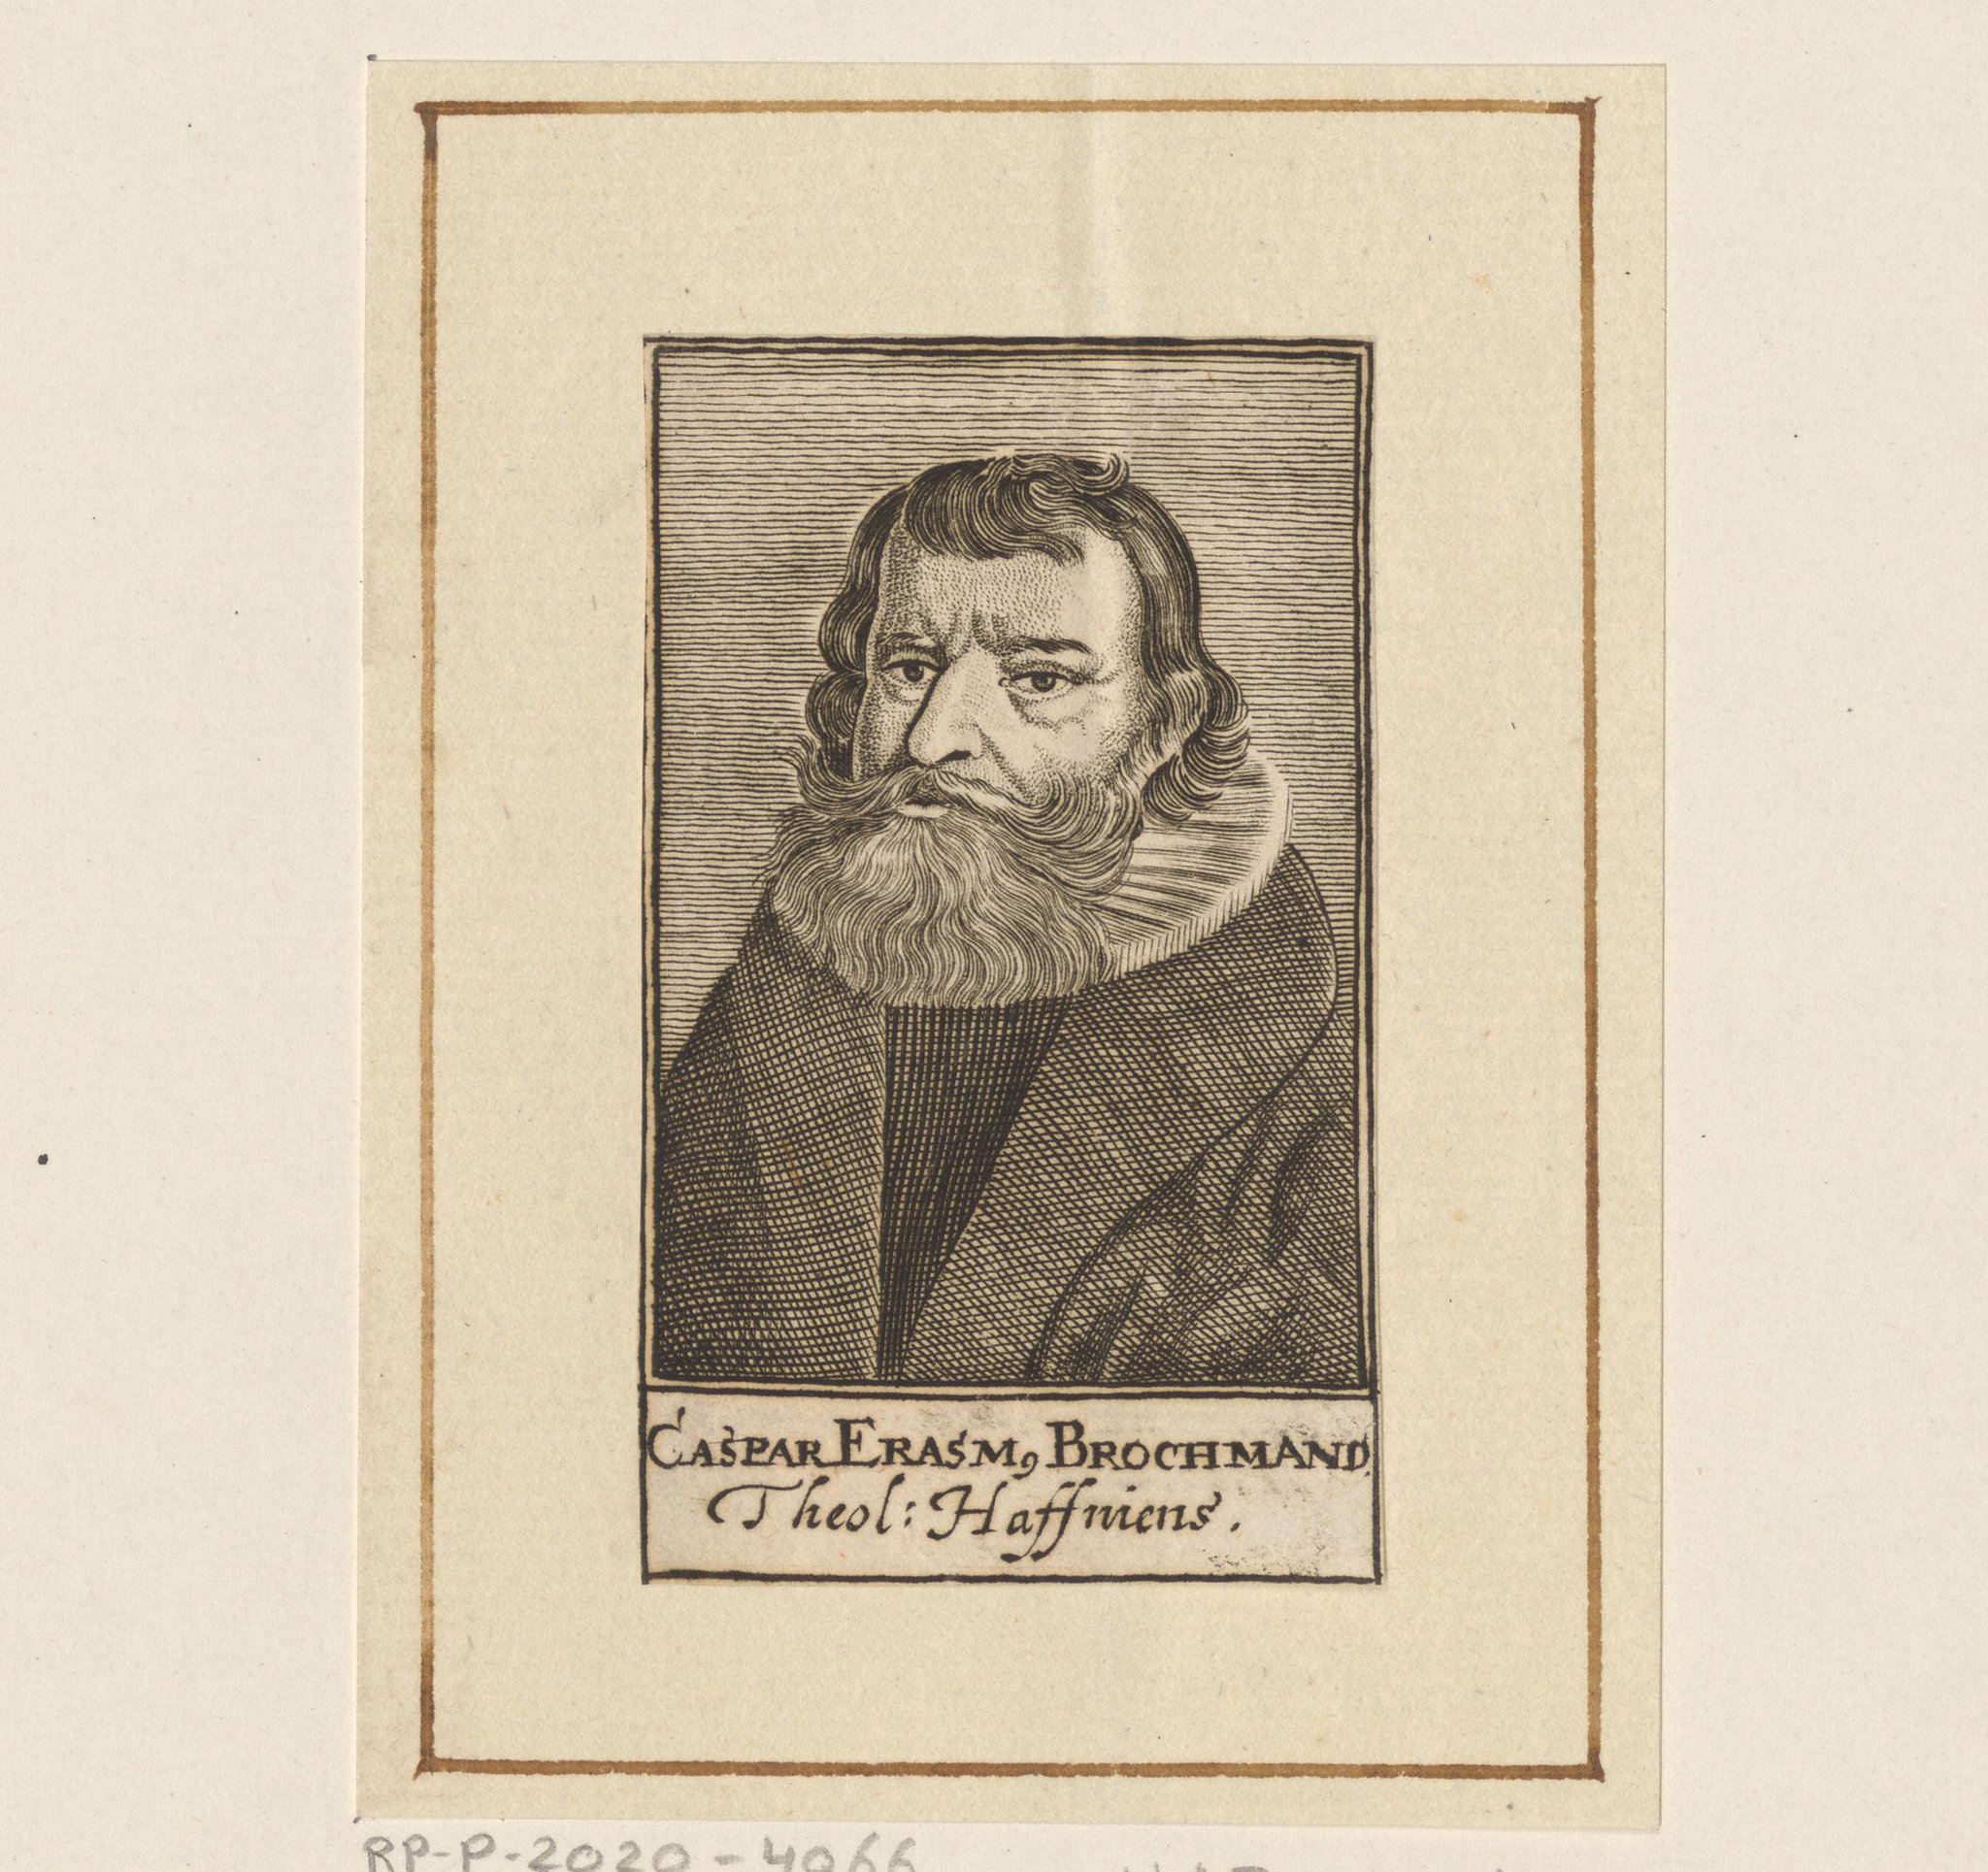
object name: book illustration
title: Portret van Caspar Erasmus Brochmand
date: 1688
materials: paper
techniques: engraving, etching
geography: nuremberg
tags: copenhagen (city), theologian, historical persons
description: Prent uit: Freher, Paul. Theatrum virorum eruditione clarorum. Neurenberg: Johann Hoffmann, 1688.